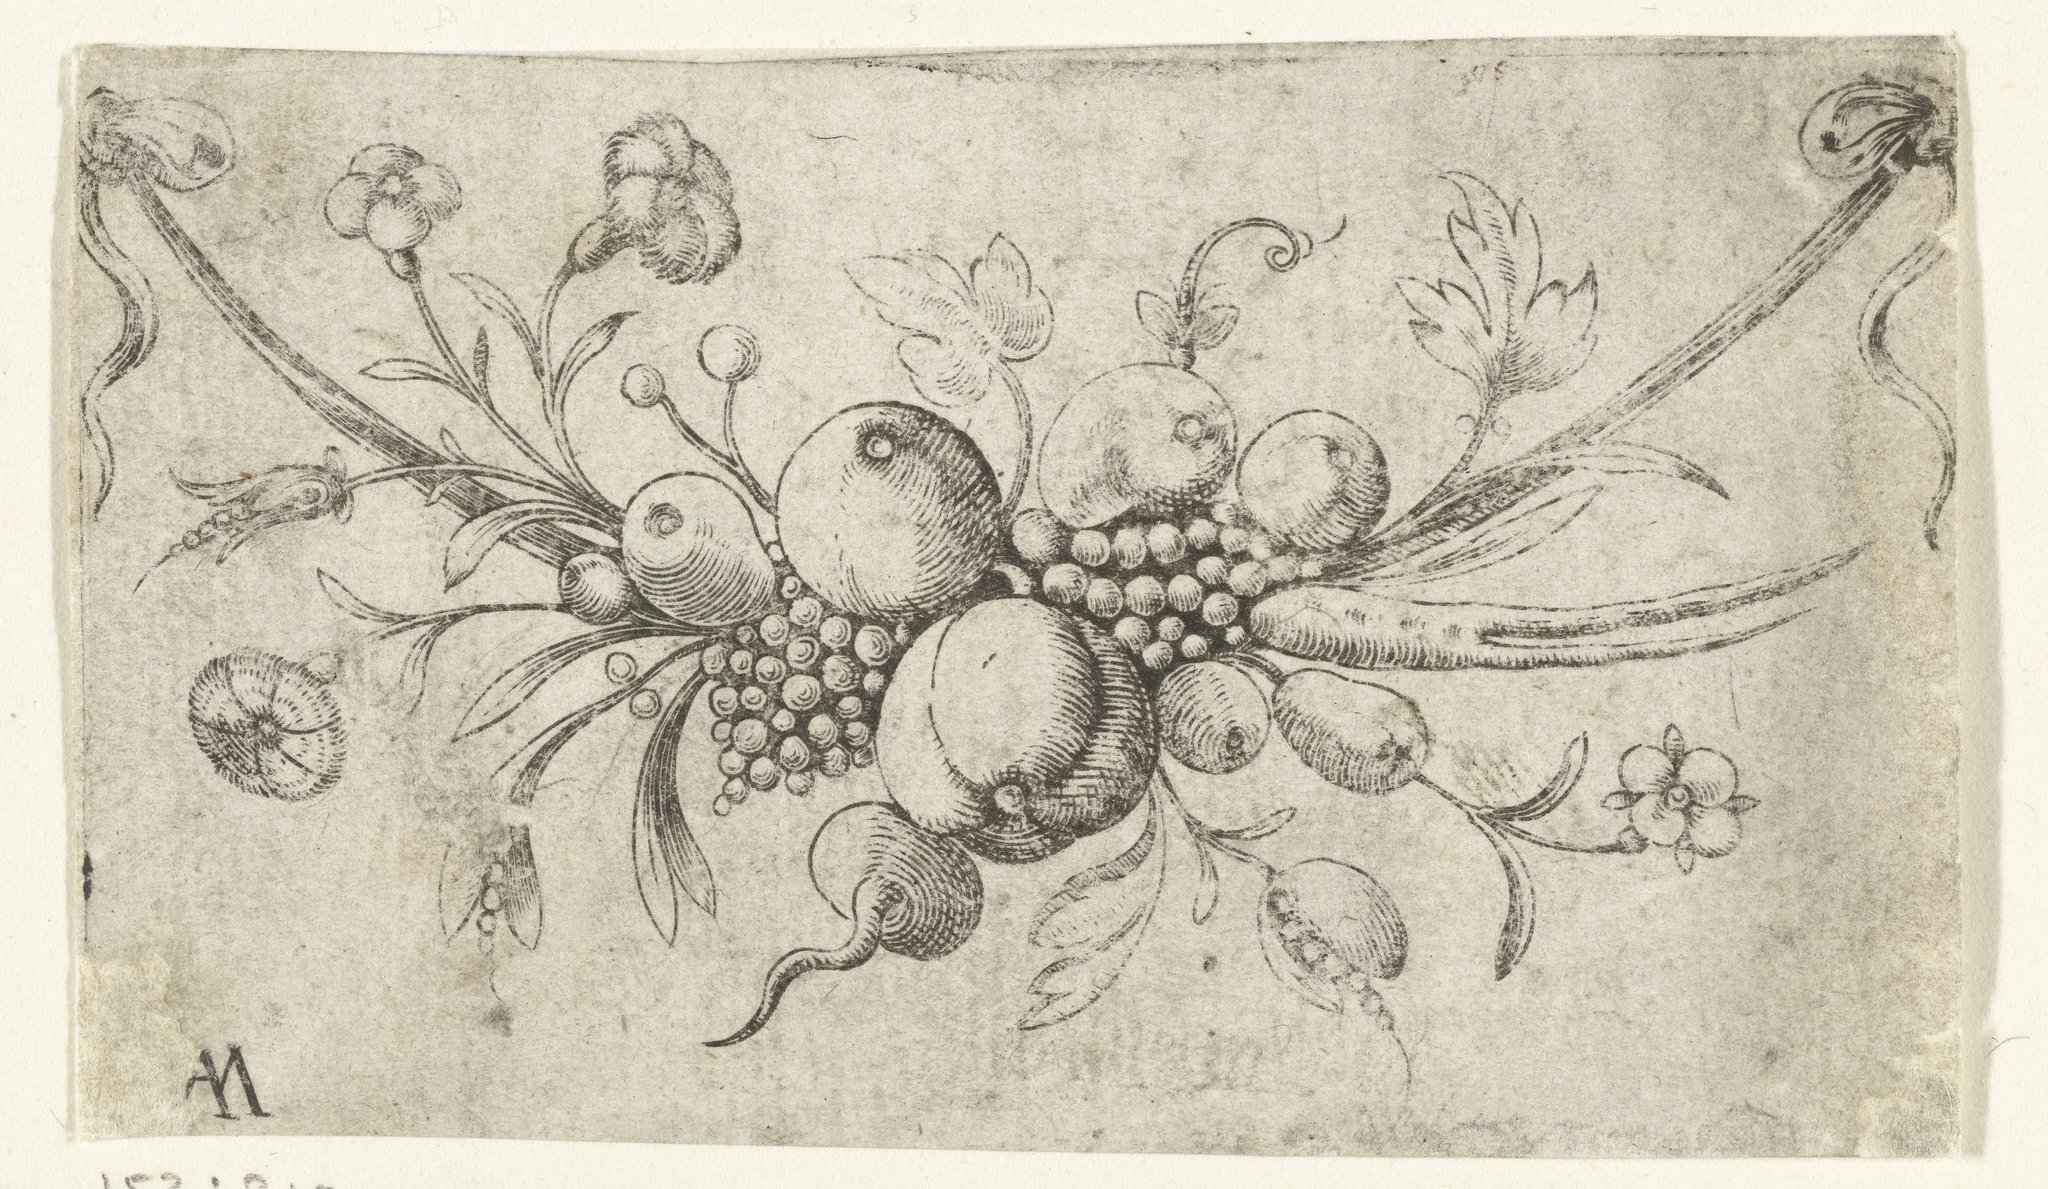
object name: ornament print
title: Guirlande van vruchten en bloemen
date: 1600-1699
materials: paper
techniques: engraving